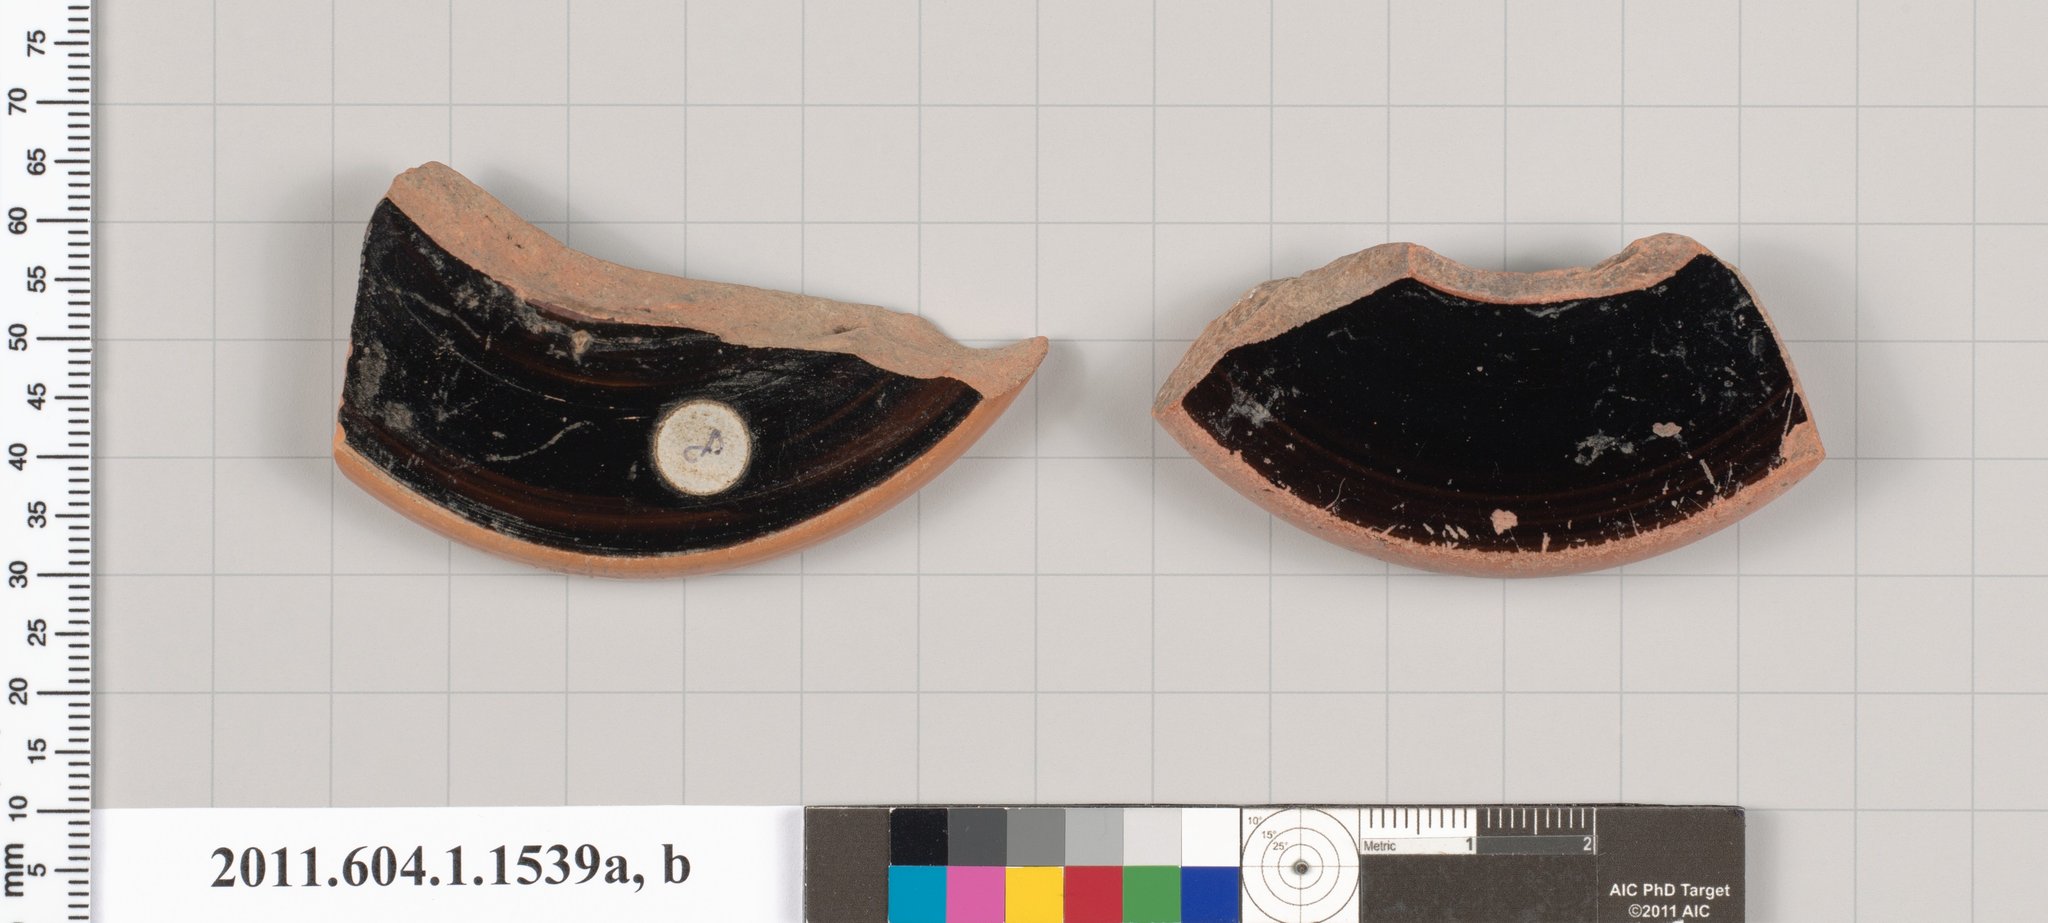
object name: kylix fragment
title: Terracotta fragments of kylikes (drinking cups)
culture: greek, attic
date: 500-401 BCE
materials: terracotta